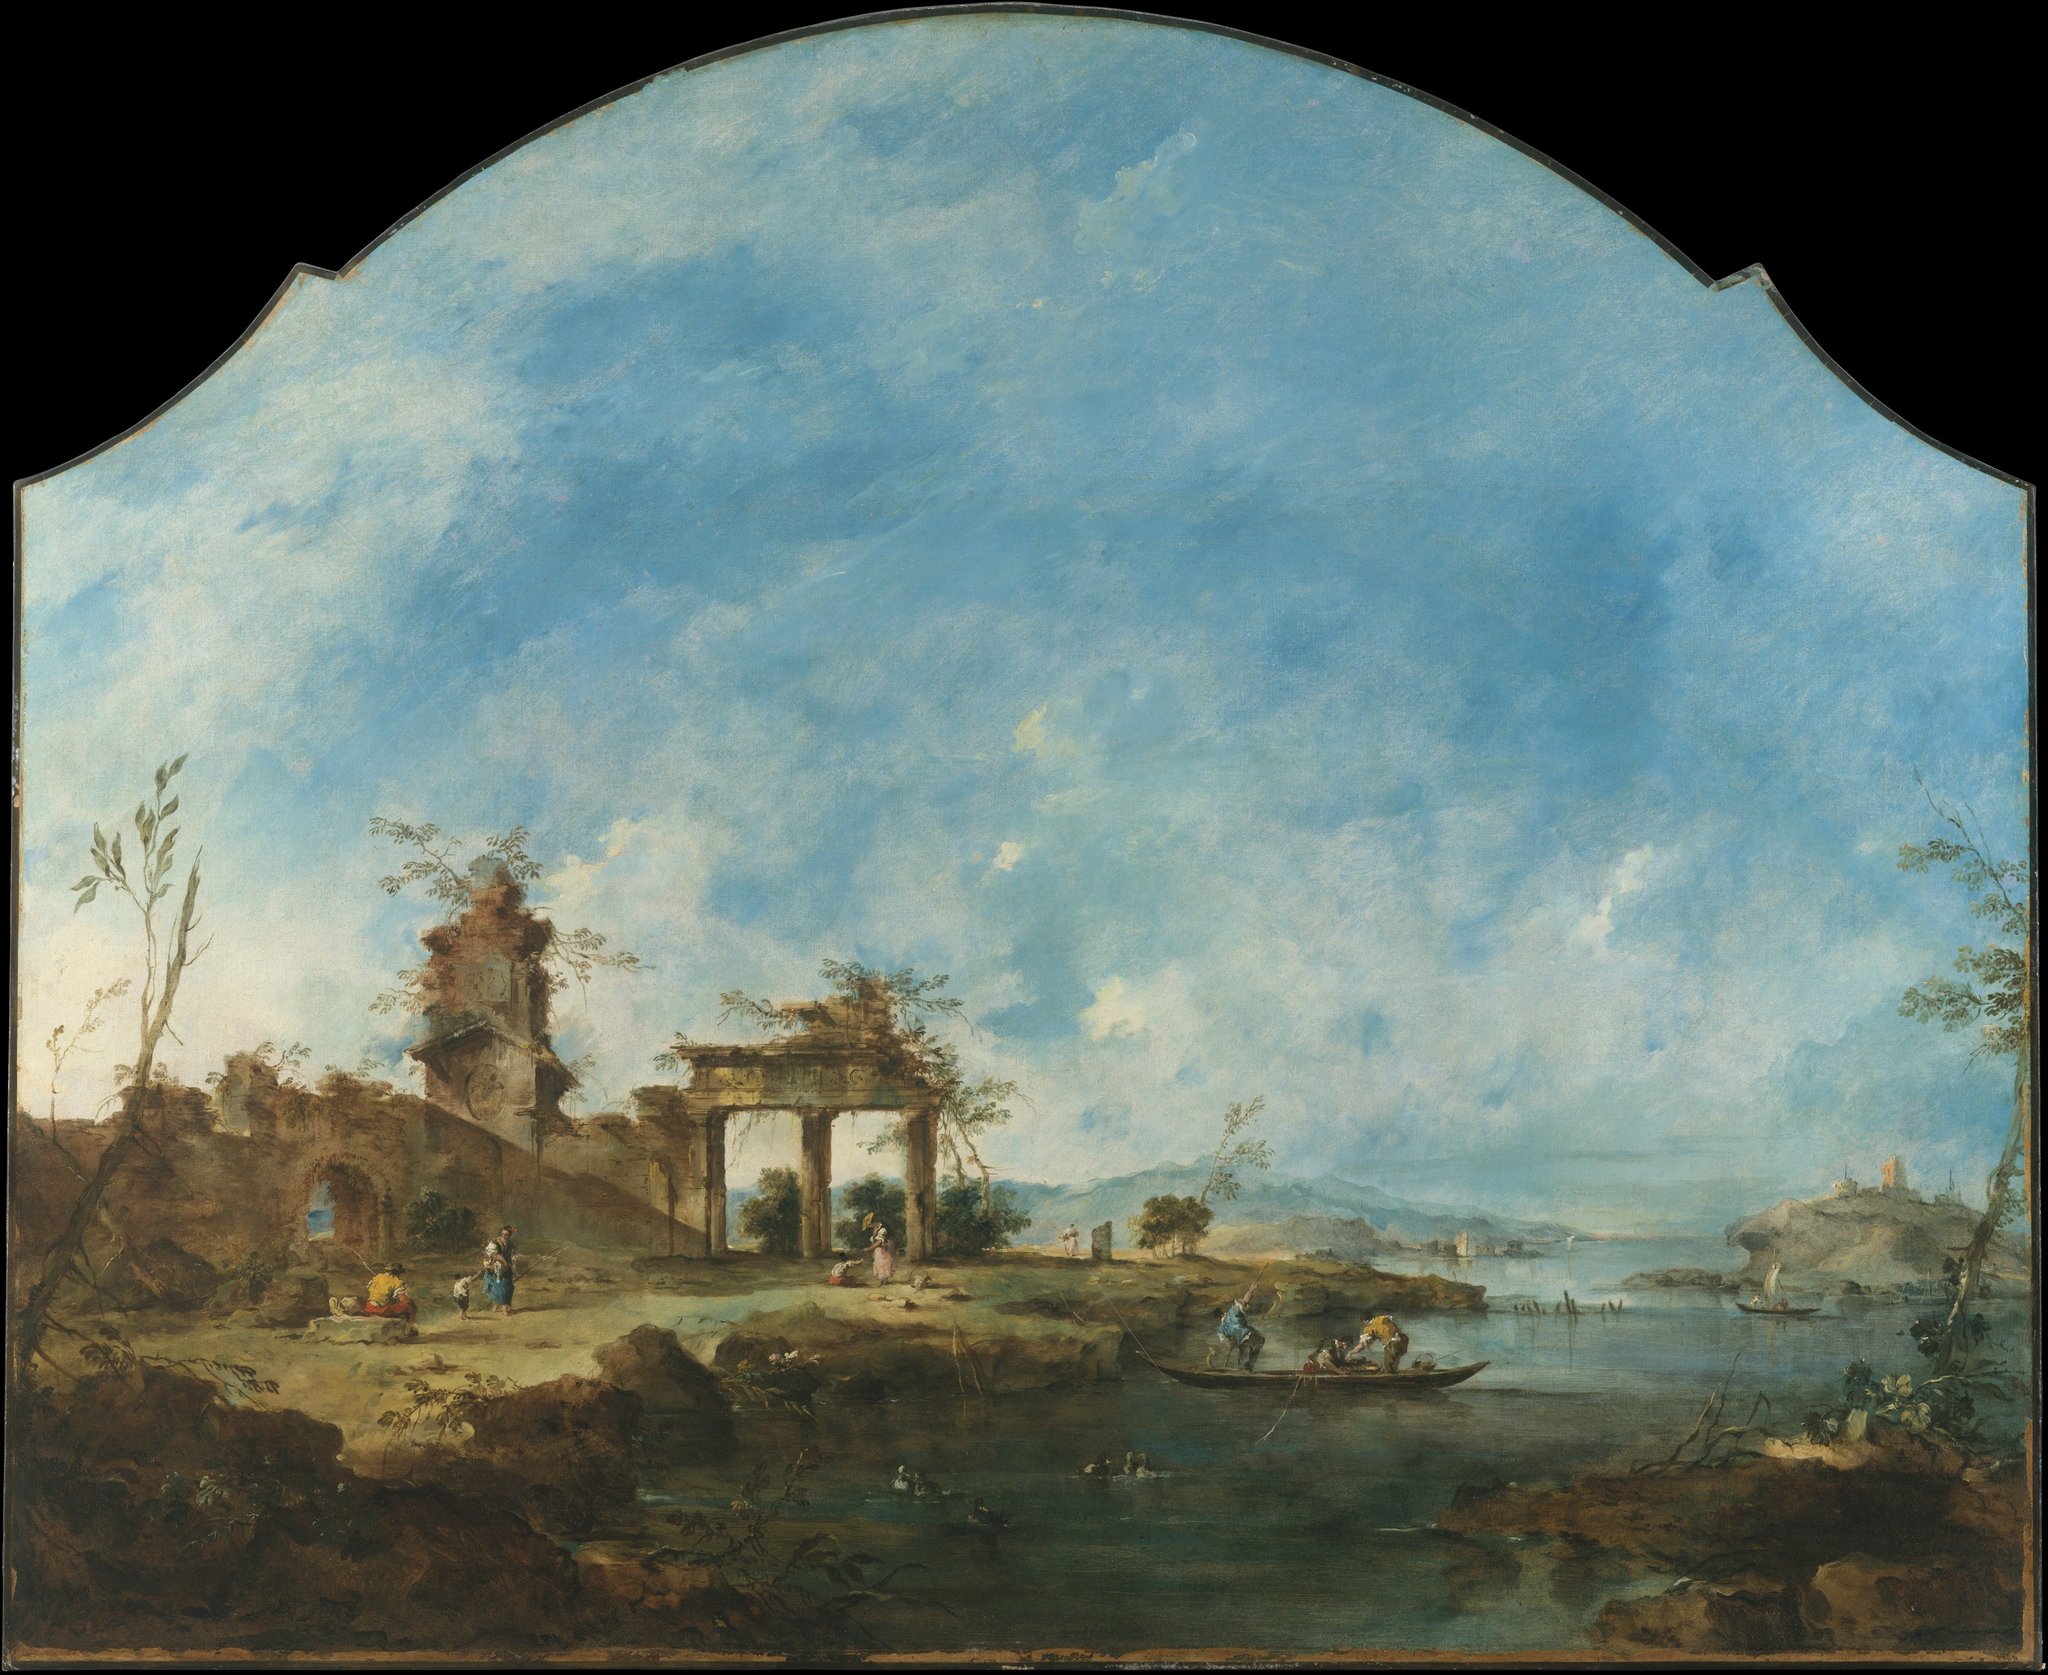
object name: painting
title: Fantastic Landscape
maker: francesco guardi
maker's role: artist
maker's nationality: italian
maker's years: 1712-1793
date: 1765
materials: canvas, oil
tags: ruins,landscapes,boats